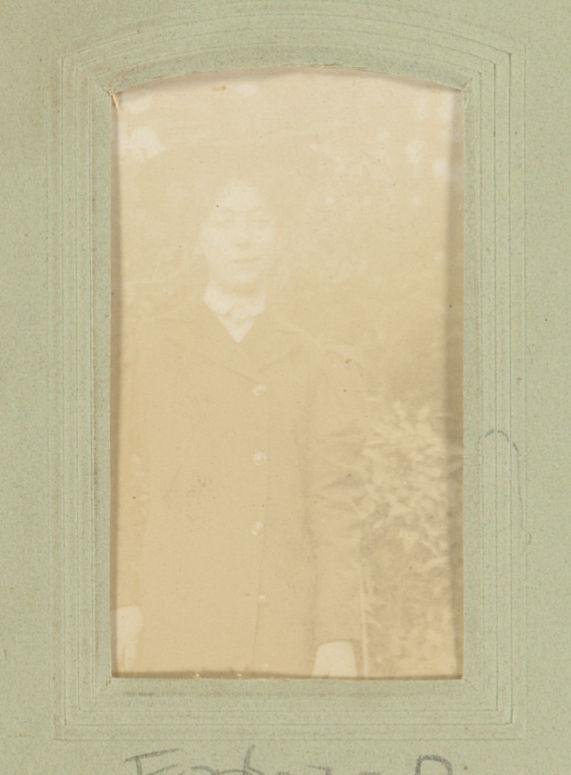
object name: photograph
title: Portret van een jonge vrouw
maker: Anonymous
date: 1890-1915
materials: photographic support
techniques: gelatin silver print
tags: adolescent, young woman, maiden, historical persons